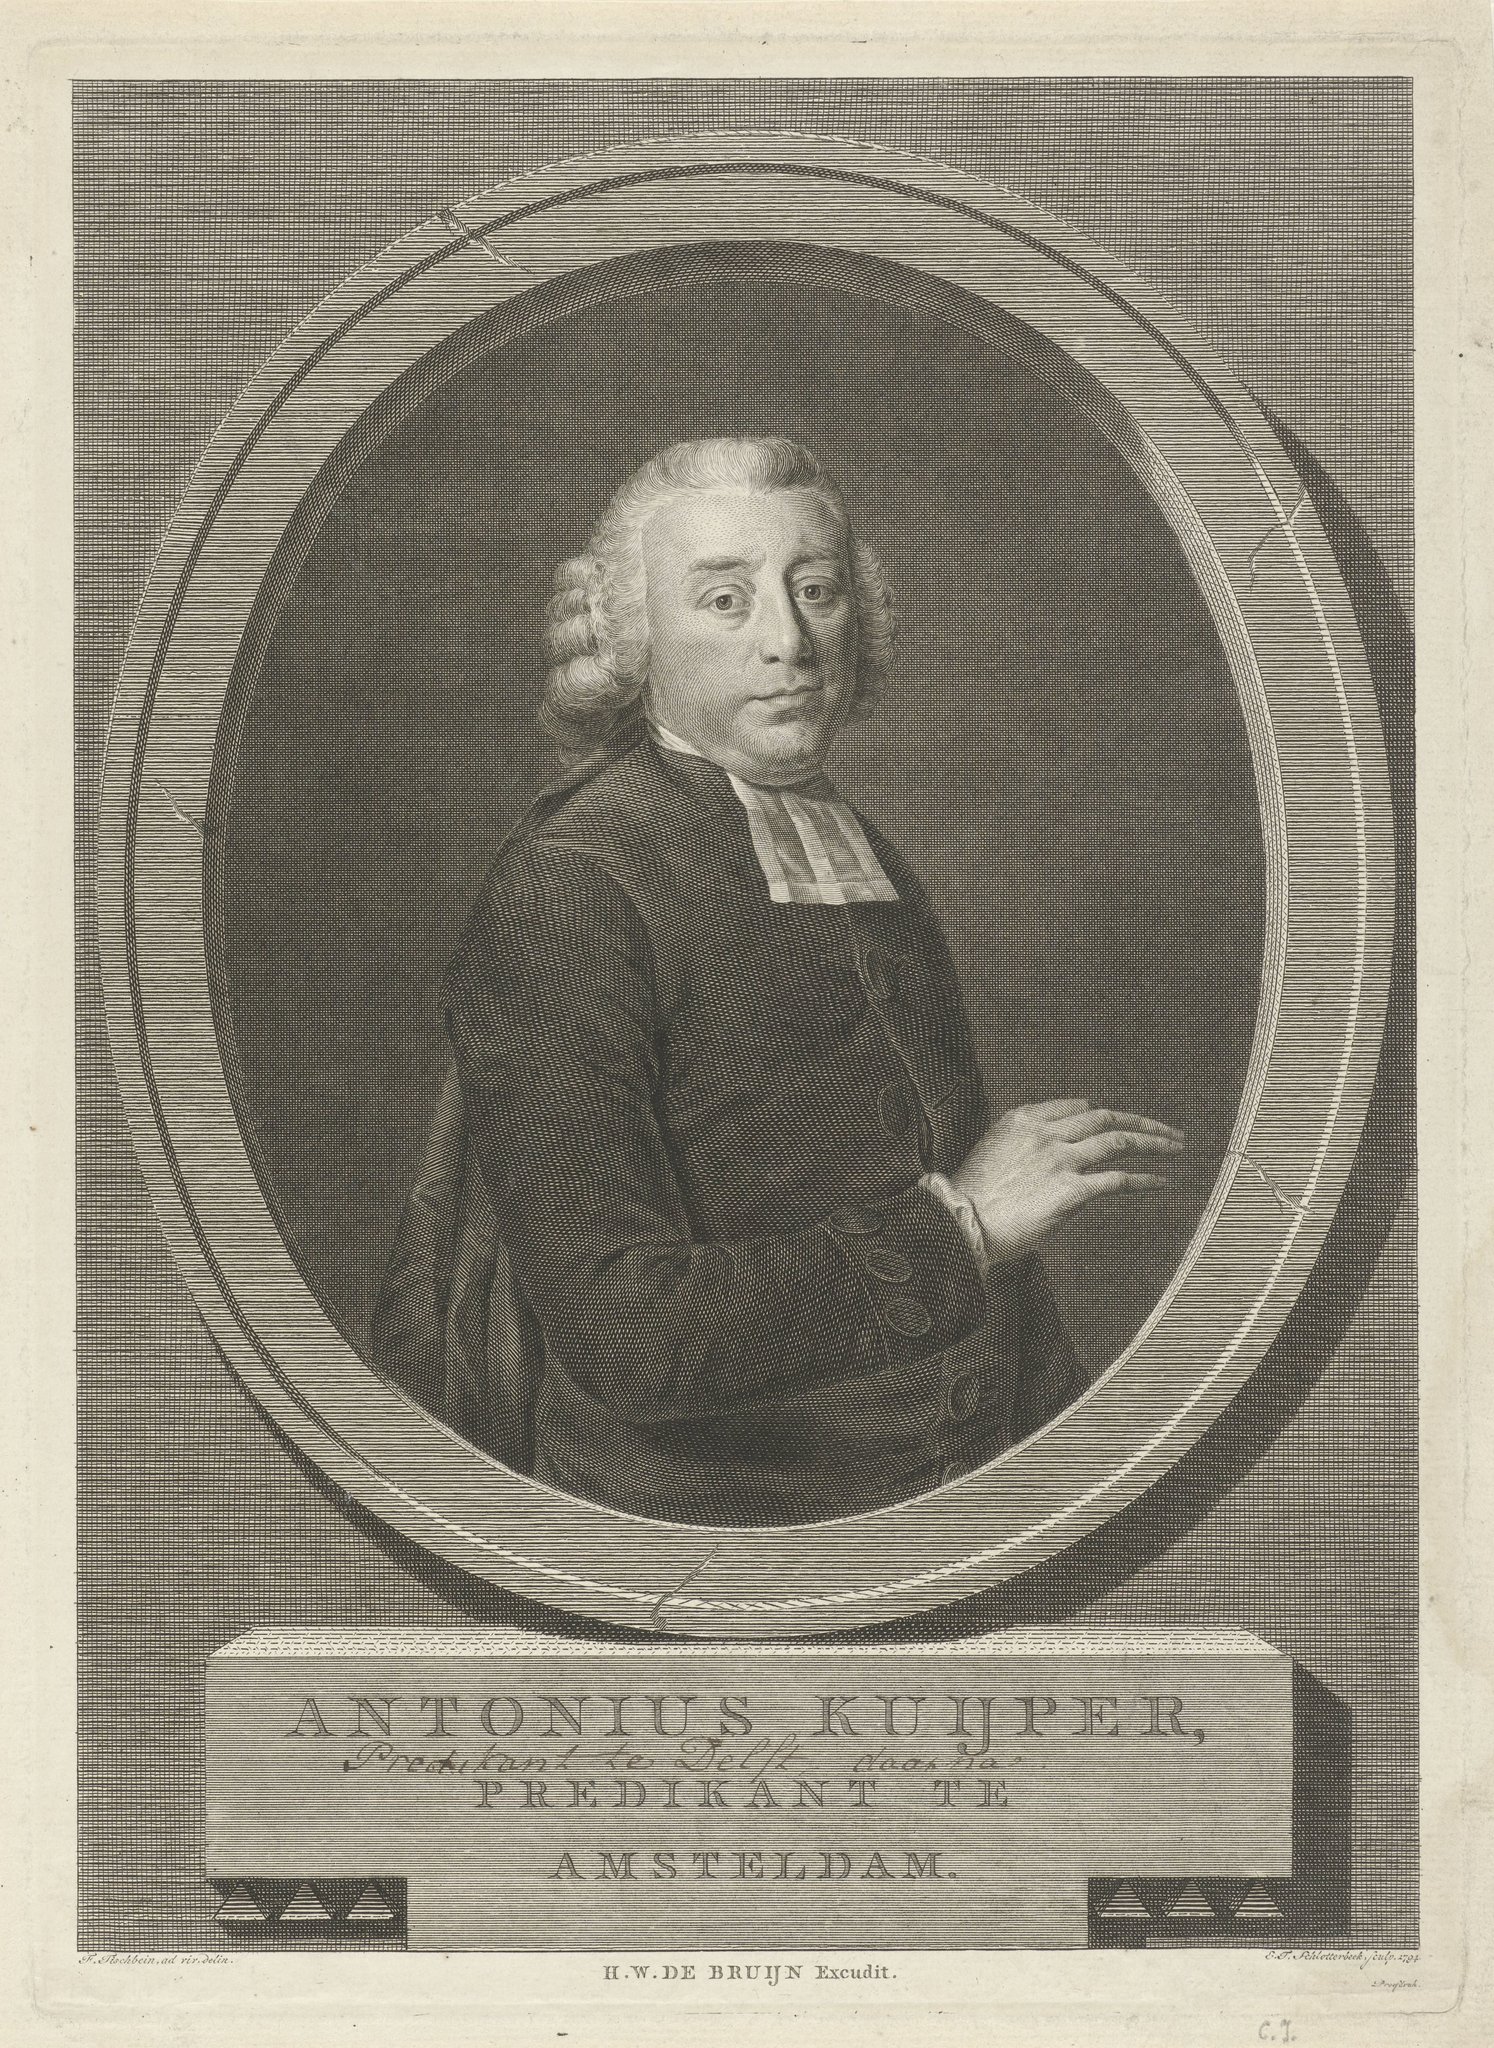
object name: print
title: Portret van Antonius Kuyper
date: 1794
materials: paper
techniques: engraving, etching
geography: netherlands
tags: wig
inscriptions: collector's mark: Lugt 2228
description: Portret van Antonius Kuyper, predikant te Delft en Amsterdam. Hij draagt een pruik en een bef.